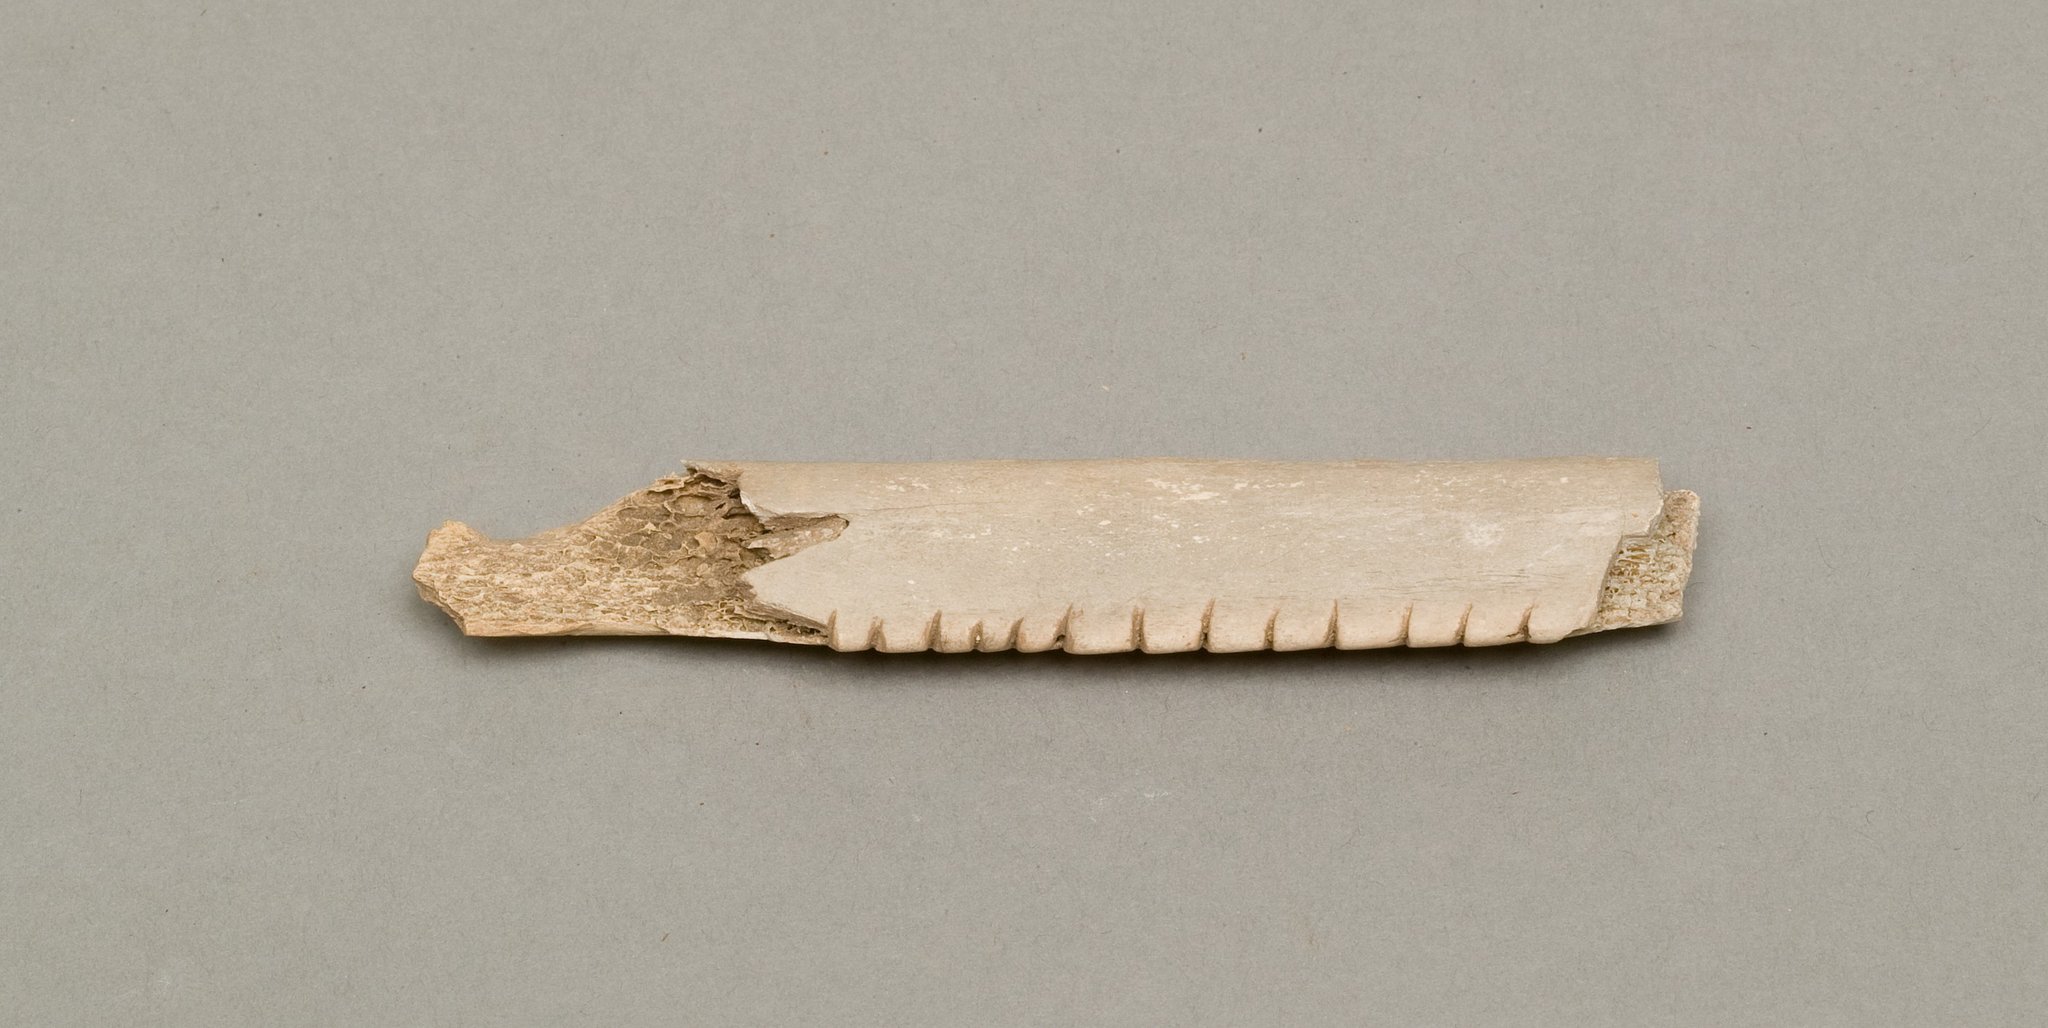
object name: notched piece of bone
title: Weaving tool (?)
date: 1295-1070 BCE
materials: bone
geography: egypt